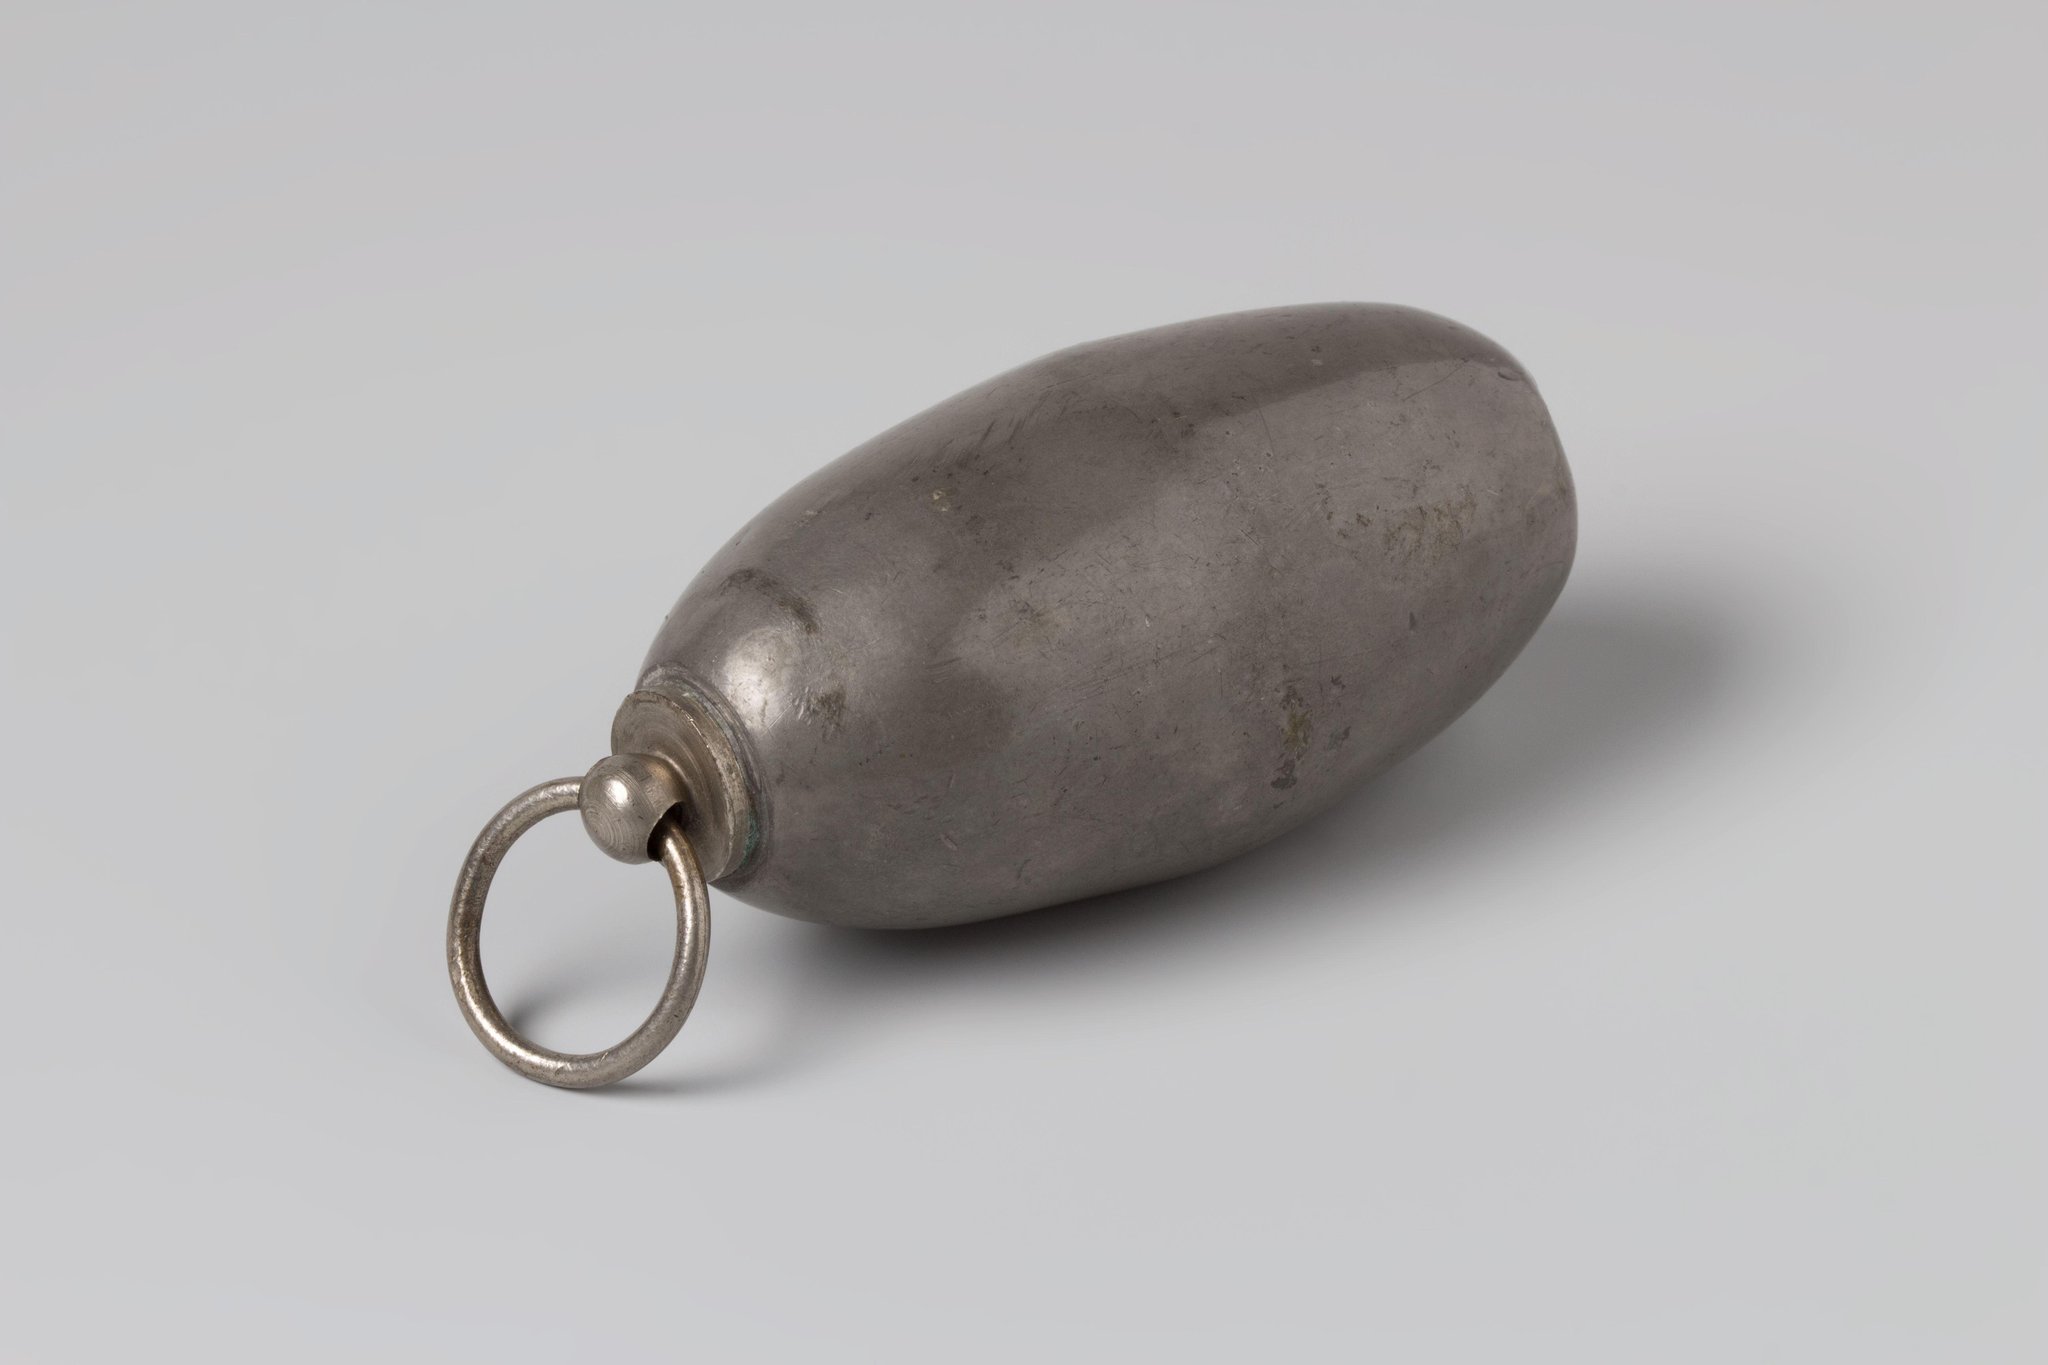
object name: jug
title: Mofkruik of gewicht van lood, ovaalvormig met aan een kant een ring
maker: Anonymous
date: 1885-1915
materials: lead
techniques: forging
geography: netherlands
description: Mofkruikje van lood (?), gevuld met water. Ovaal, oog aan de bovenste platte kant, waardoor een grote ring.